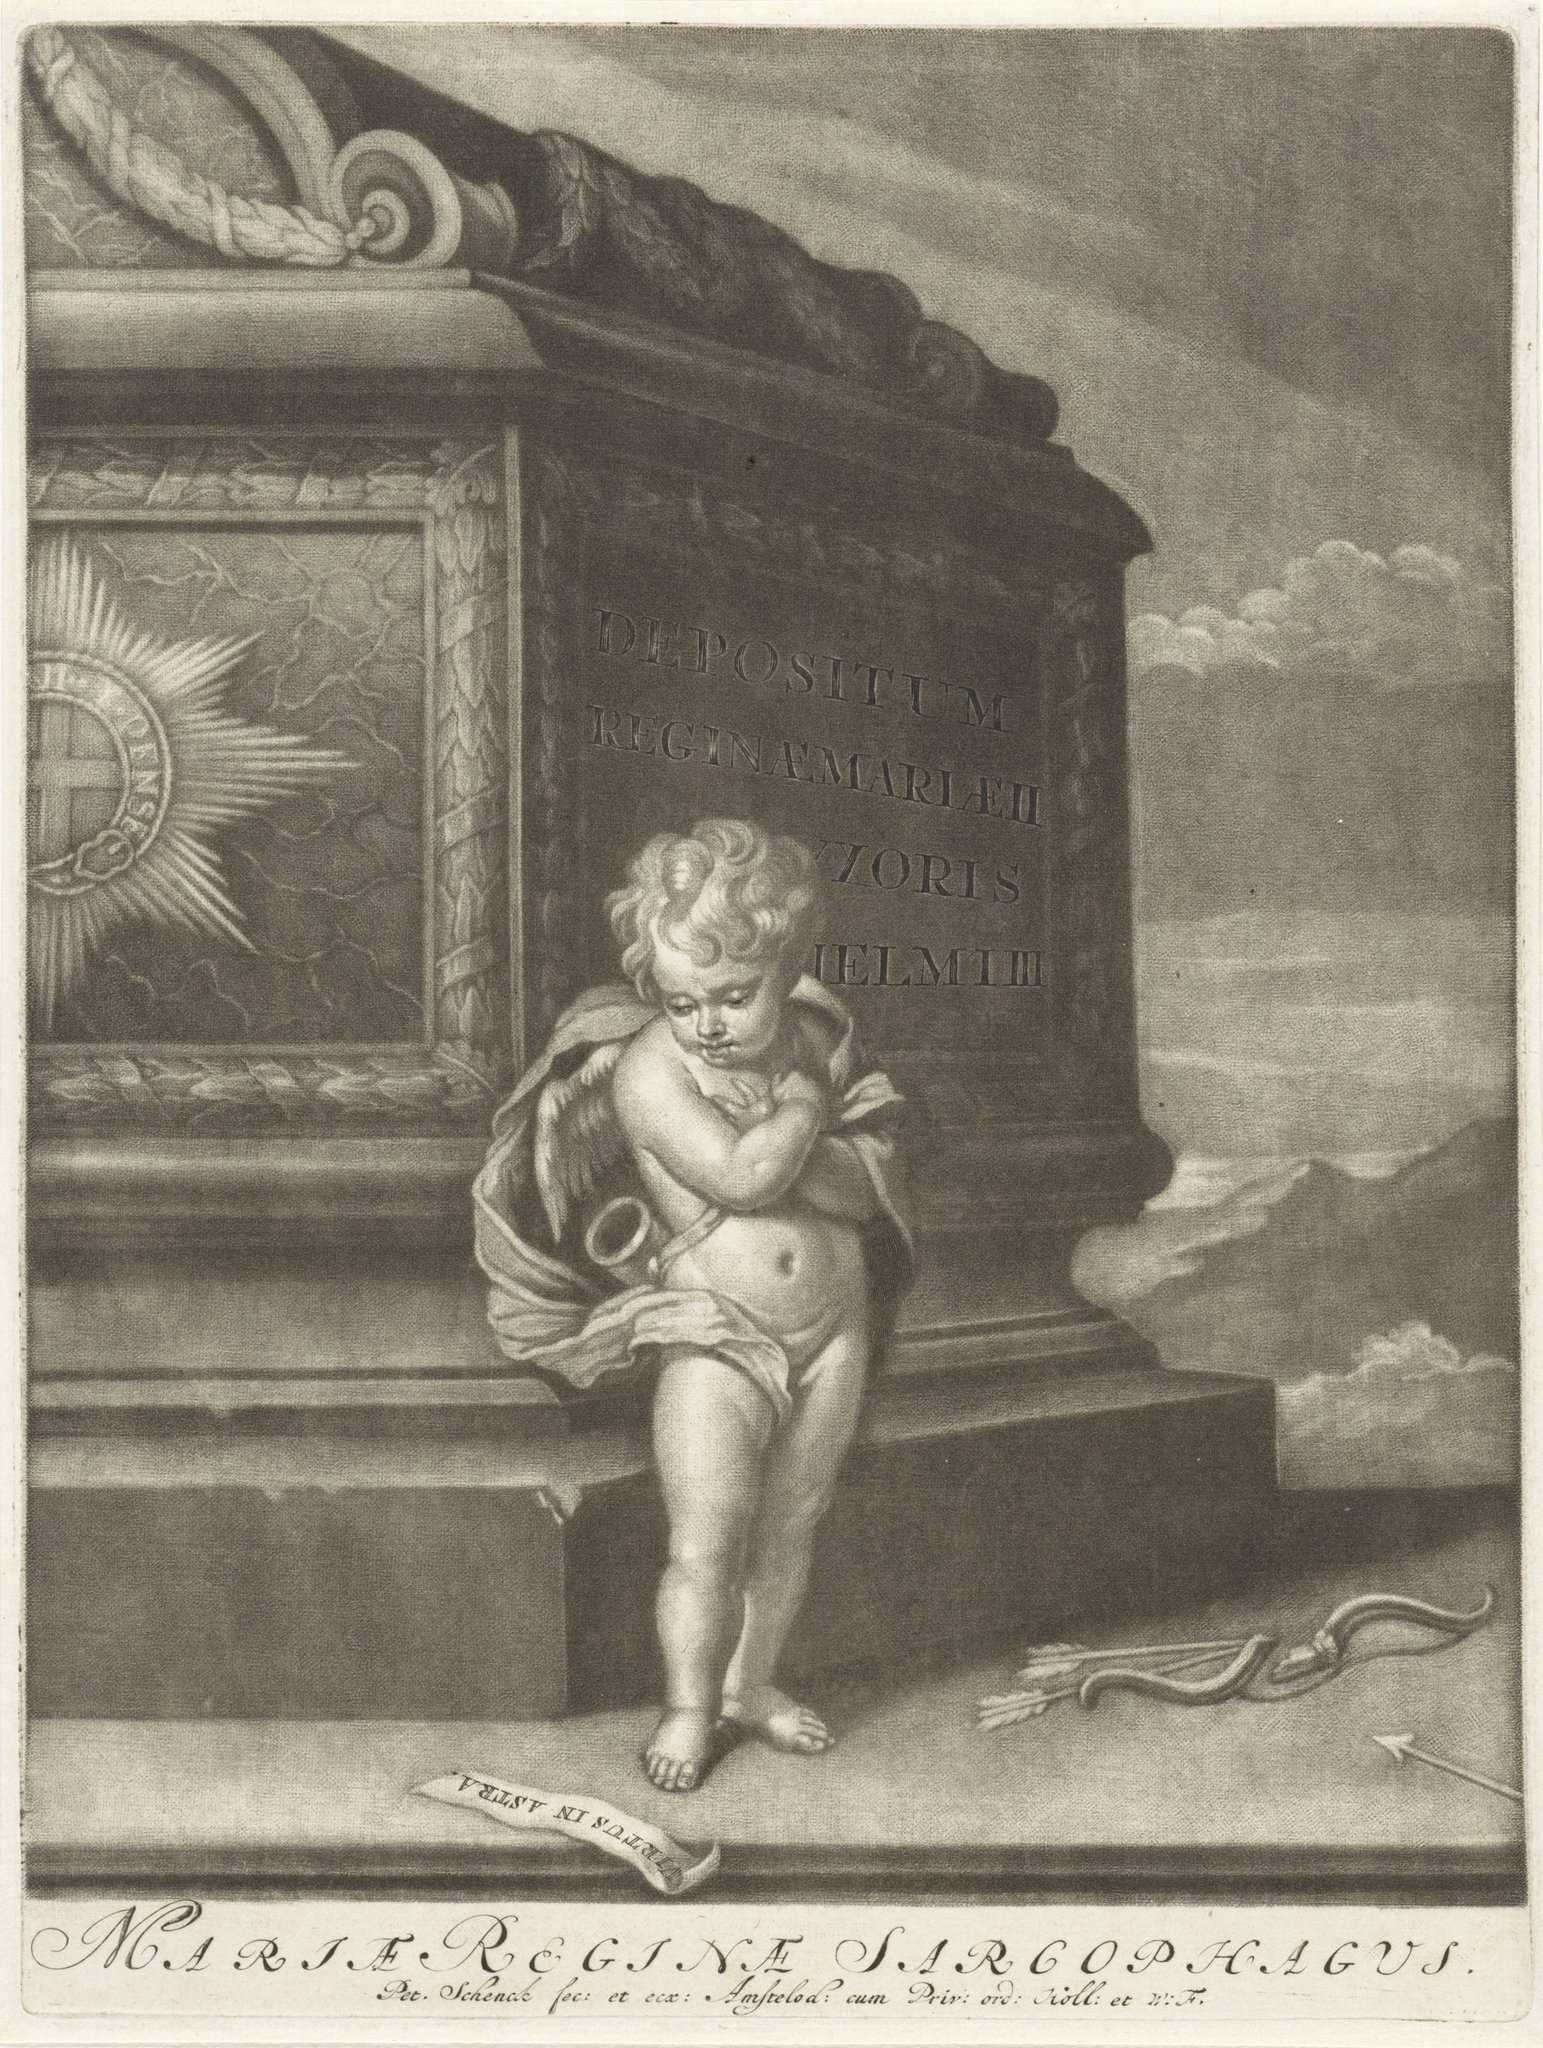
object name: print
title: Zinneprent ter nagedachtenis aan Maria Stuart, 1695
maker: pieter schenk (i)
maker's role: print maker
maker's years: 1660-1711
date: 1695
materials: paper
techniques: engraving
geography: amsterdam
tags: maria ii stuart (koningin van engeland, schotland en ierland), gravestone, tombstone, fettered cupid, 'amor cruciatus', specific aspects of cupid, grave-building, monumental tomb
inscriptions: collector's mark: Lugt 2228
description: Allegorische voorstelling vervaardigd ter nagedachtenis aan Maria II Stuart, overleden op 7 januari 1695. Een treurende Amor staat bij het graf van de koningin. Zijn pijl en boog liggen gebroken op de grond. Op het strookje papier dat op de grond ligt staat de tekst 'Virtus in Astra'.